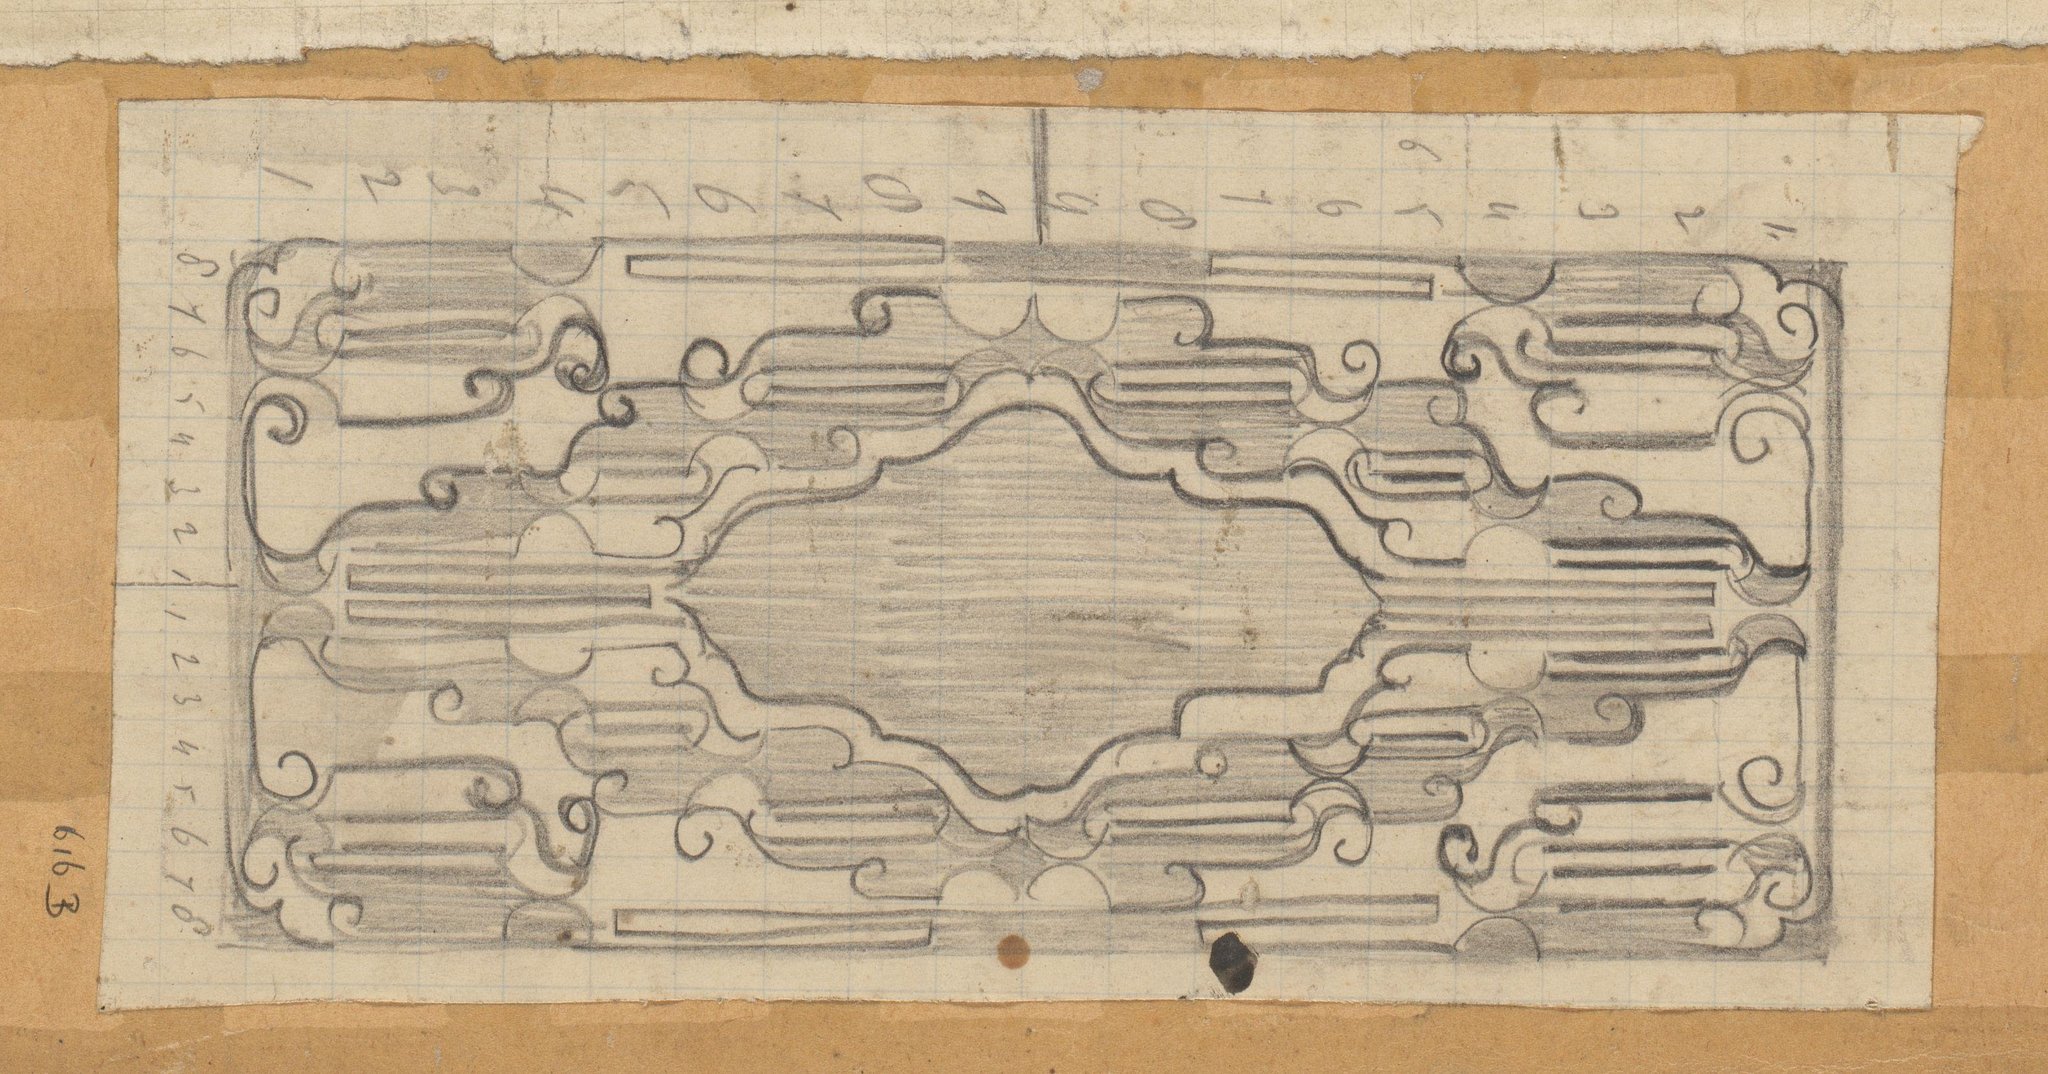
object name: design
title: Decoratief ontwerp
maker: carel adolph lion cachet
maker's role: draughtsman, print maker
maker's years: 1864-1945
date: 1874-1945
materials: pencil